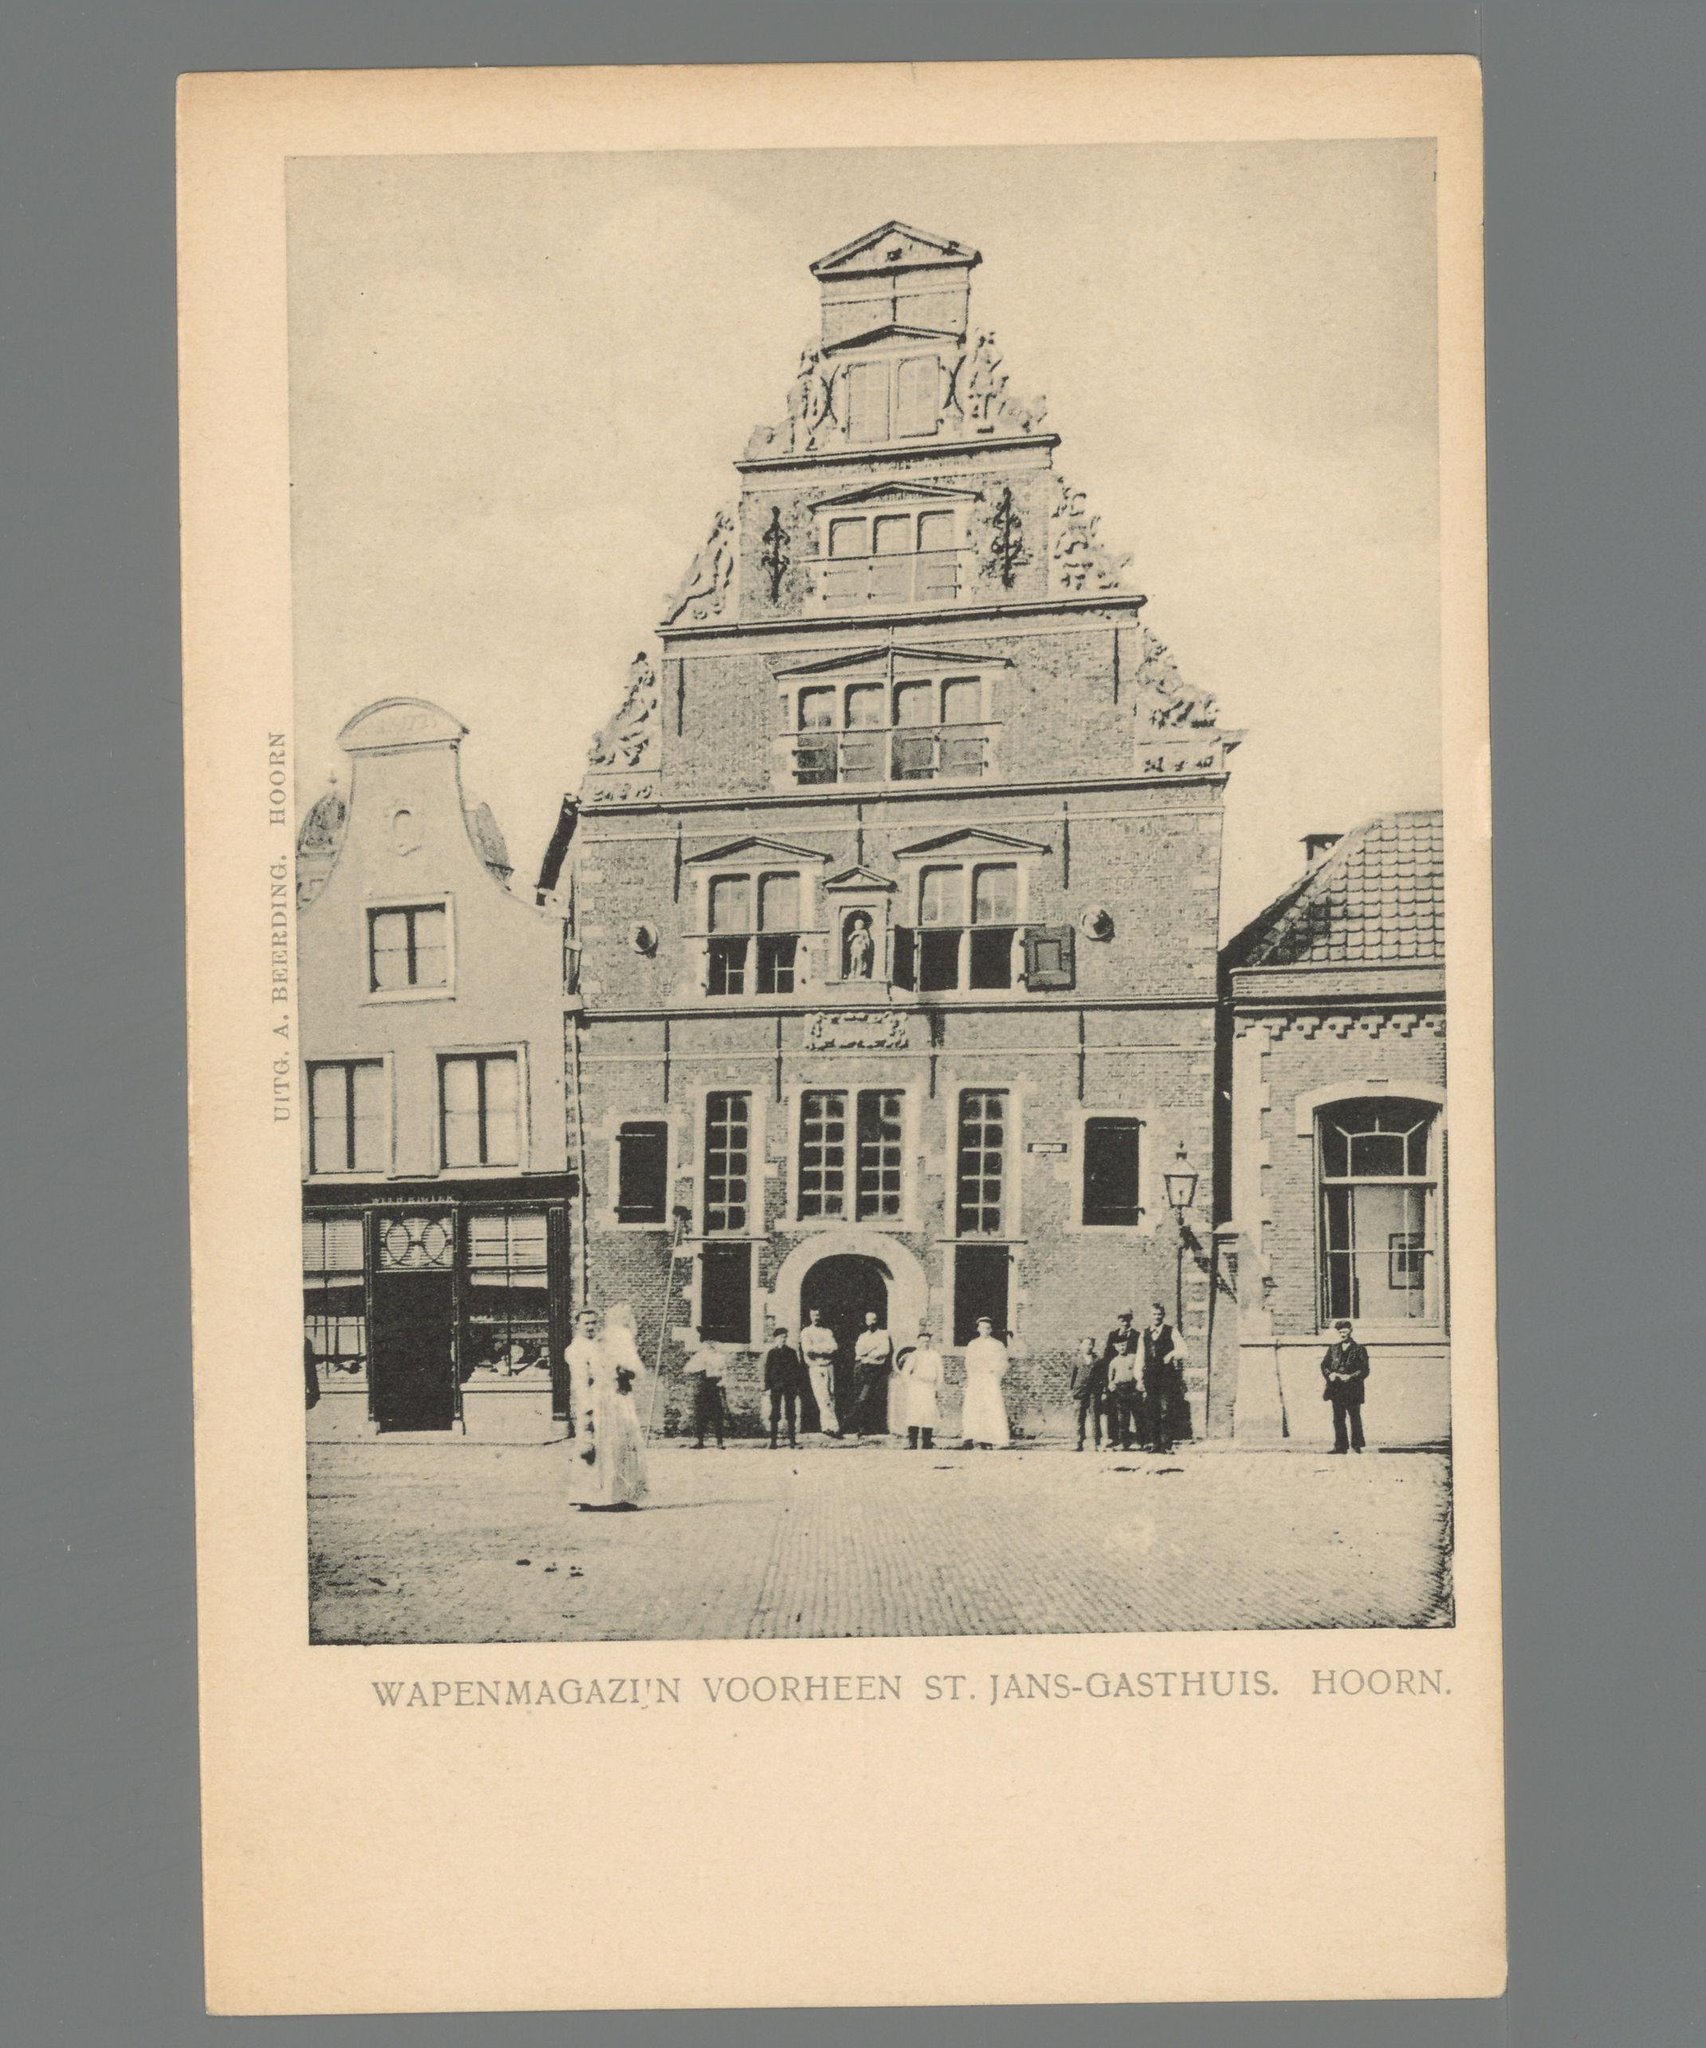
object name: photomechanical print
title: Wapenmagazijn voorheen St. Jans-Gasthuis. Hoorn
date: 1900-1905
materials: cardboard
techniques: photograph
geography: hoorn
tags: city-view, and landscape with man-made constructions, ammunition store, arsenal, hoorn (north holland)